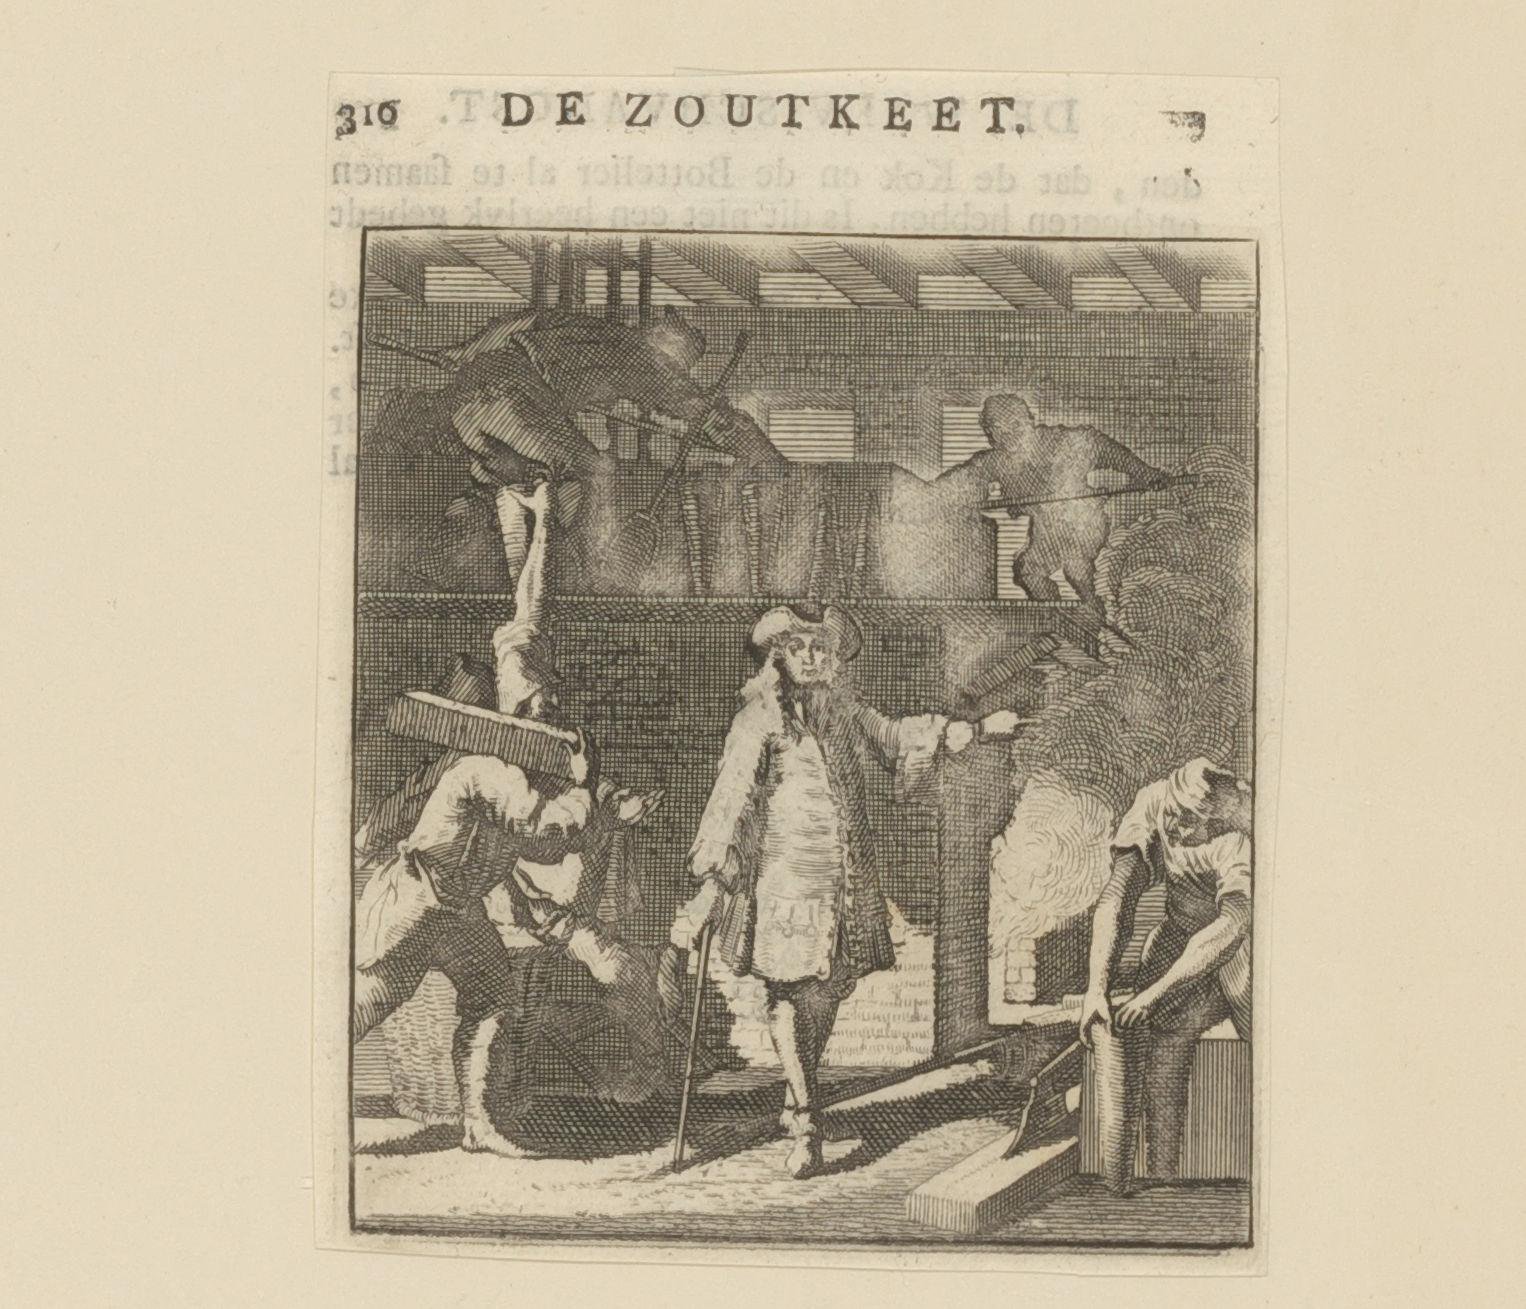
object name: print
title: Zoutmijn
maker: Anonymous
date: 1719-1759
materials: paper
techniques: etching, letterpress printing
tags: miner, salt, mining, handicrafts, craftsman at work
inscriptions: stamp, collector's mark: Lugt 1641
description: Prent met andere letterzetting gebruikt in: St. Clara, Abraham van. Iets voor allen. [Vertaald door] J. le Long. Amsterdam: Janssoons van Waesberge, 1719, dl. 2. En in: St. Clara, Abraham van. Iets voor allen. [Vertaald door] J. le Long. Amsterdam: Jan Roman de Jonge, 1741, dl. 2. En in: St. Clara, Abraham van. Iets voor allen. [Vertaald door] J. le Long. Amsterdam: Jan Roman, 1759, dl. 2. Huidige prent uit een andere editie. Naar een prent van: Jan Luyken.